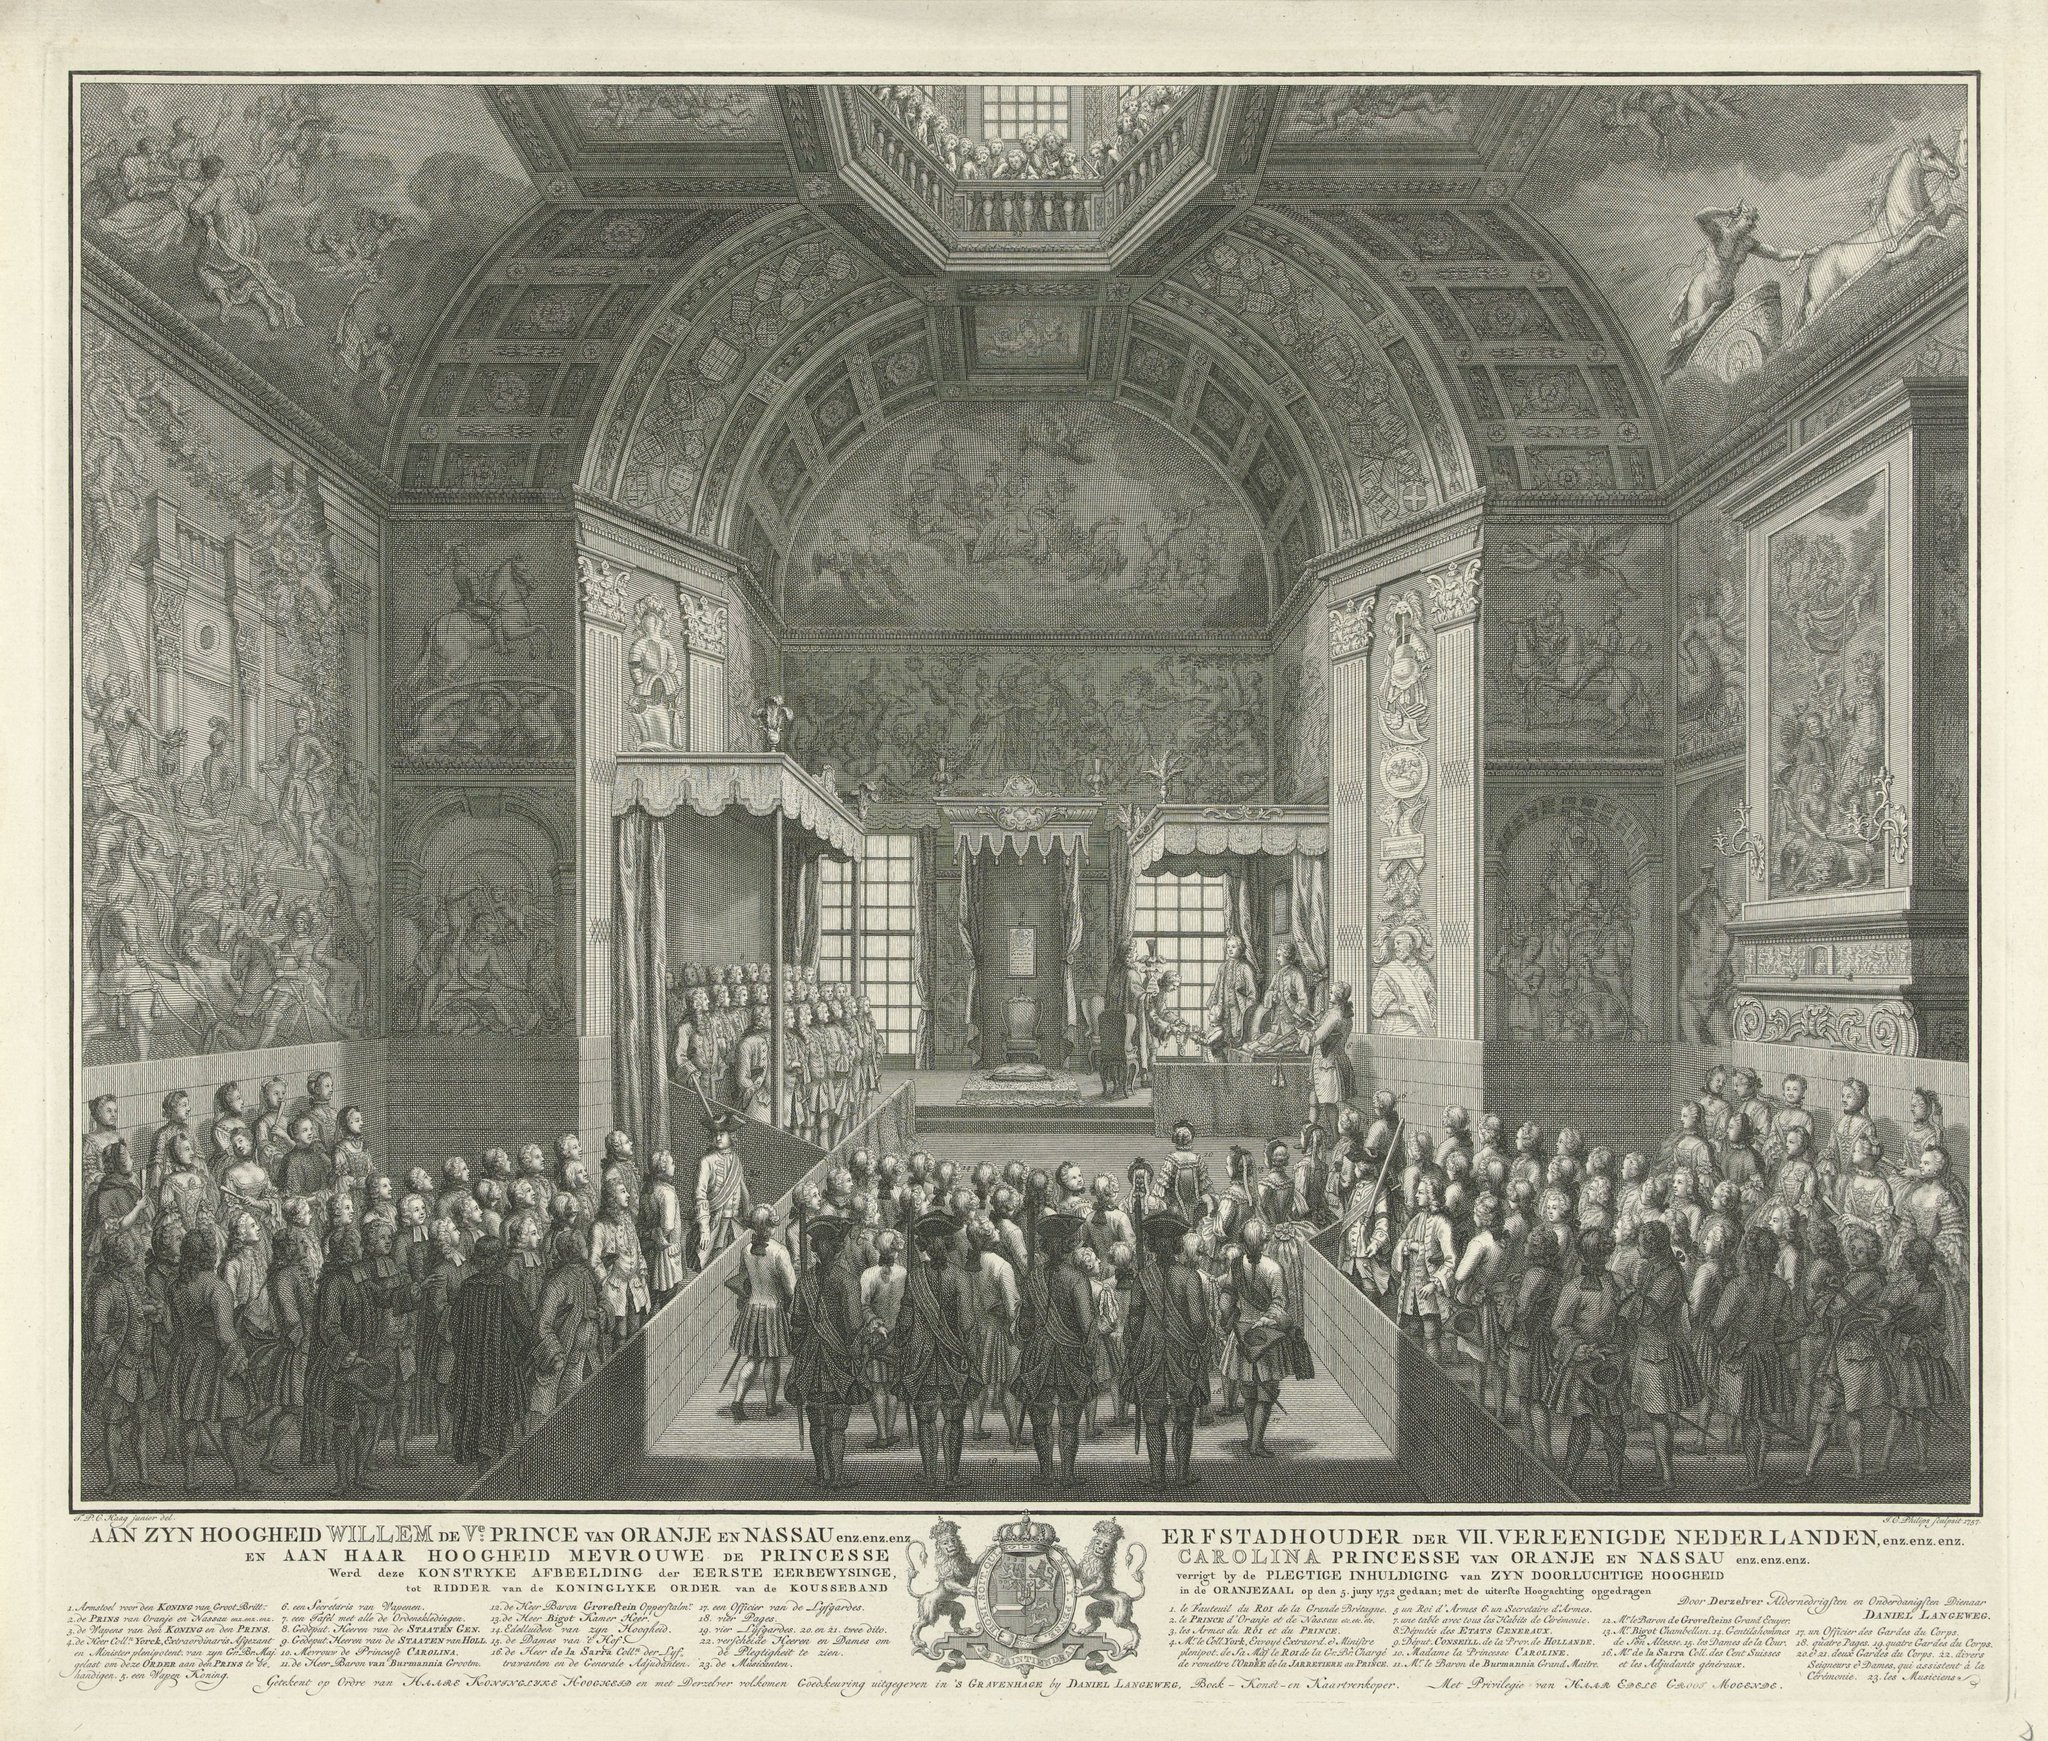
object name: print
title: Inhuldiging van prins Willem V tot Ridder in de Orde van de Kousenband, 1752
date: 1757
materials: paper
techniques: engraving, etching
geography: the hague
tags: the hague, william v (prince of orange), knighting ceremonies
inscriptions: collector's mark: Lugt 2228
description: De plechtige inhuldiging van prins Willem V tot Ridder in de Orde van de Kousenband, in de Oranjezaal in Paleis Huis Ten Bosch, 5 juni 1752. De prins krijgt ten overstaan van de vele aanwezigen de ordeketen overhandigd. In de plaat het onderschrift met de legenda 1-23 in het Nederlands en Frans en het wapen van de prins.